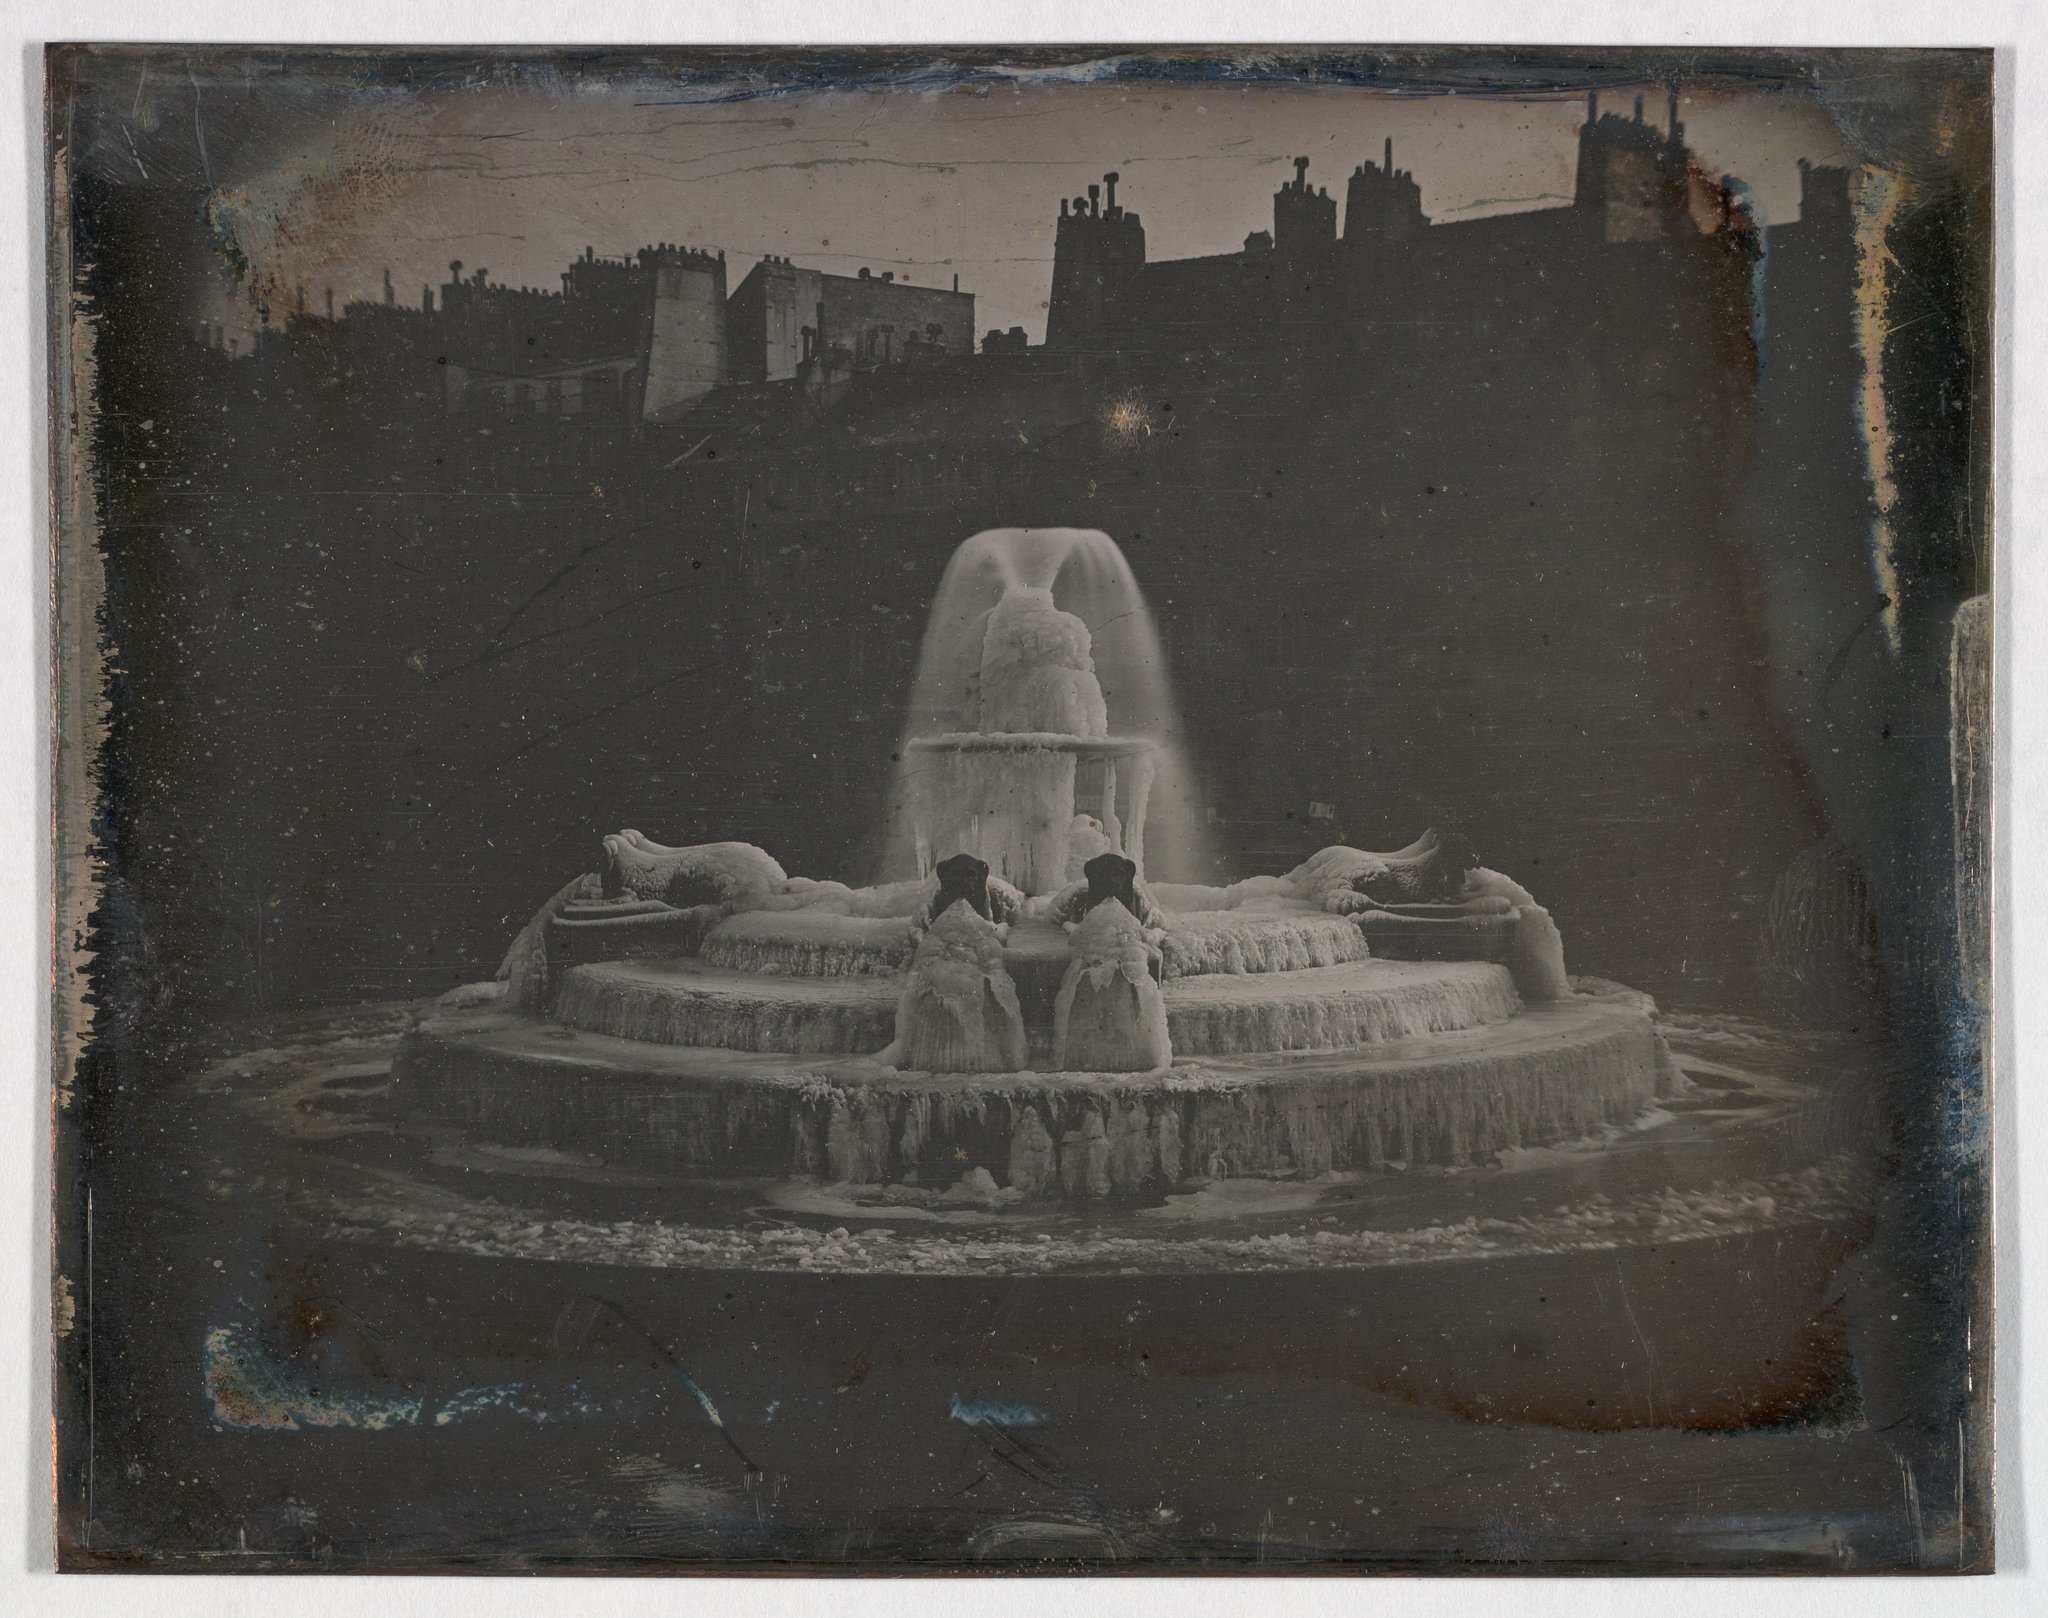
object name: photograph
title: Fountain, Place du Château d’Eau, Paris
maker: joseph-philibert girault de prangey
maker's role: artist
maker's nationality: french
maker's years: 1804-1892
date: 1841-1842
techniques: daguerreotype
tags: fountains,paris